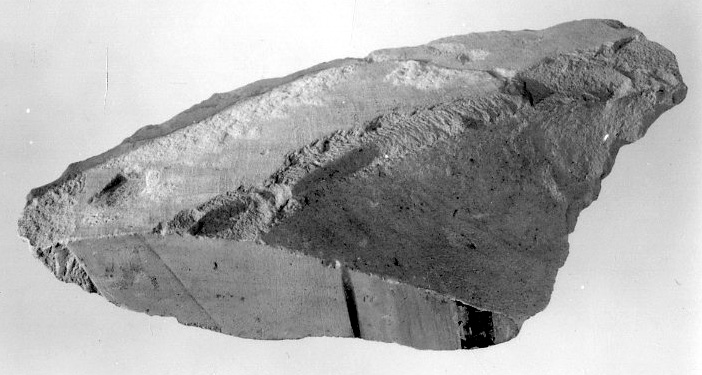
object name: relief fragment, tomb of meketre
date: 1981-1975 BCE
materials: limestone, paint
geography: egypt